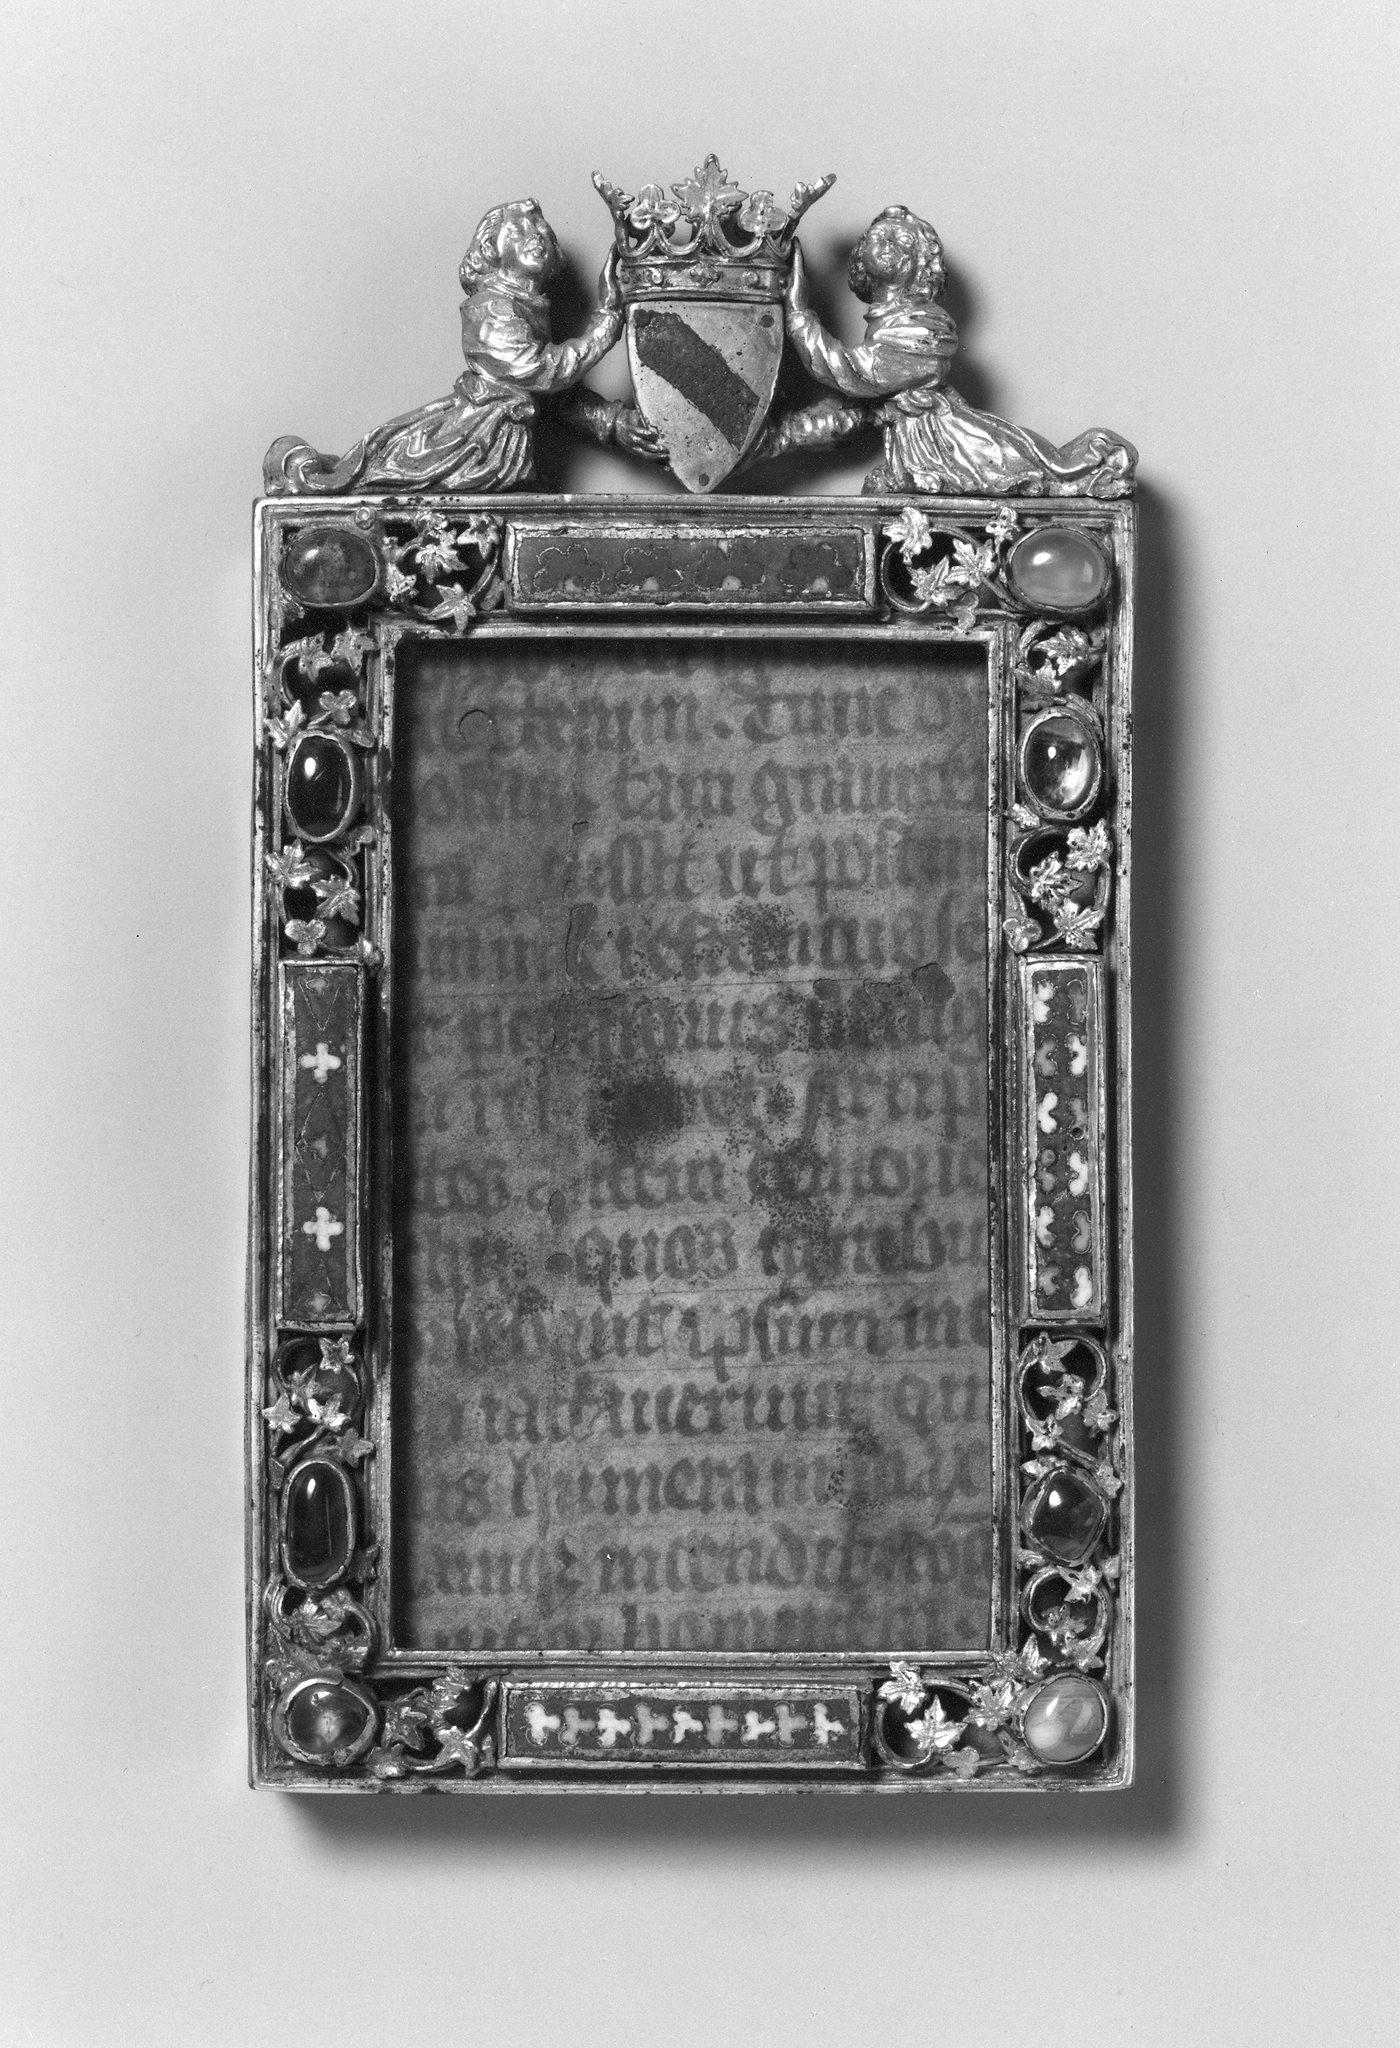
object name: frame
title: Enamelled frame with angels holding coat-of-arms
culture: french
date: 1201-1300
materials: enamel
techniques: enamel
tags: angels,coat of arms